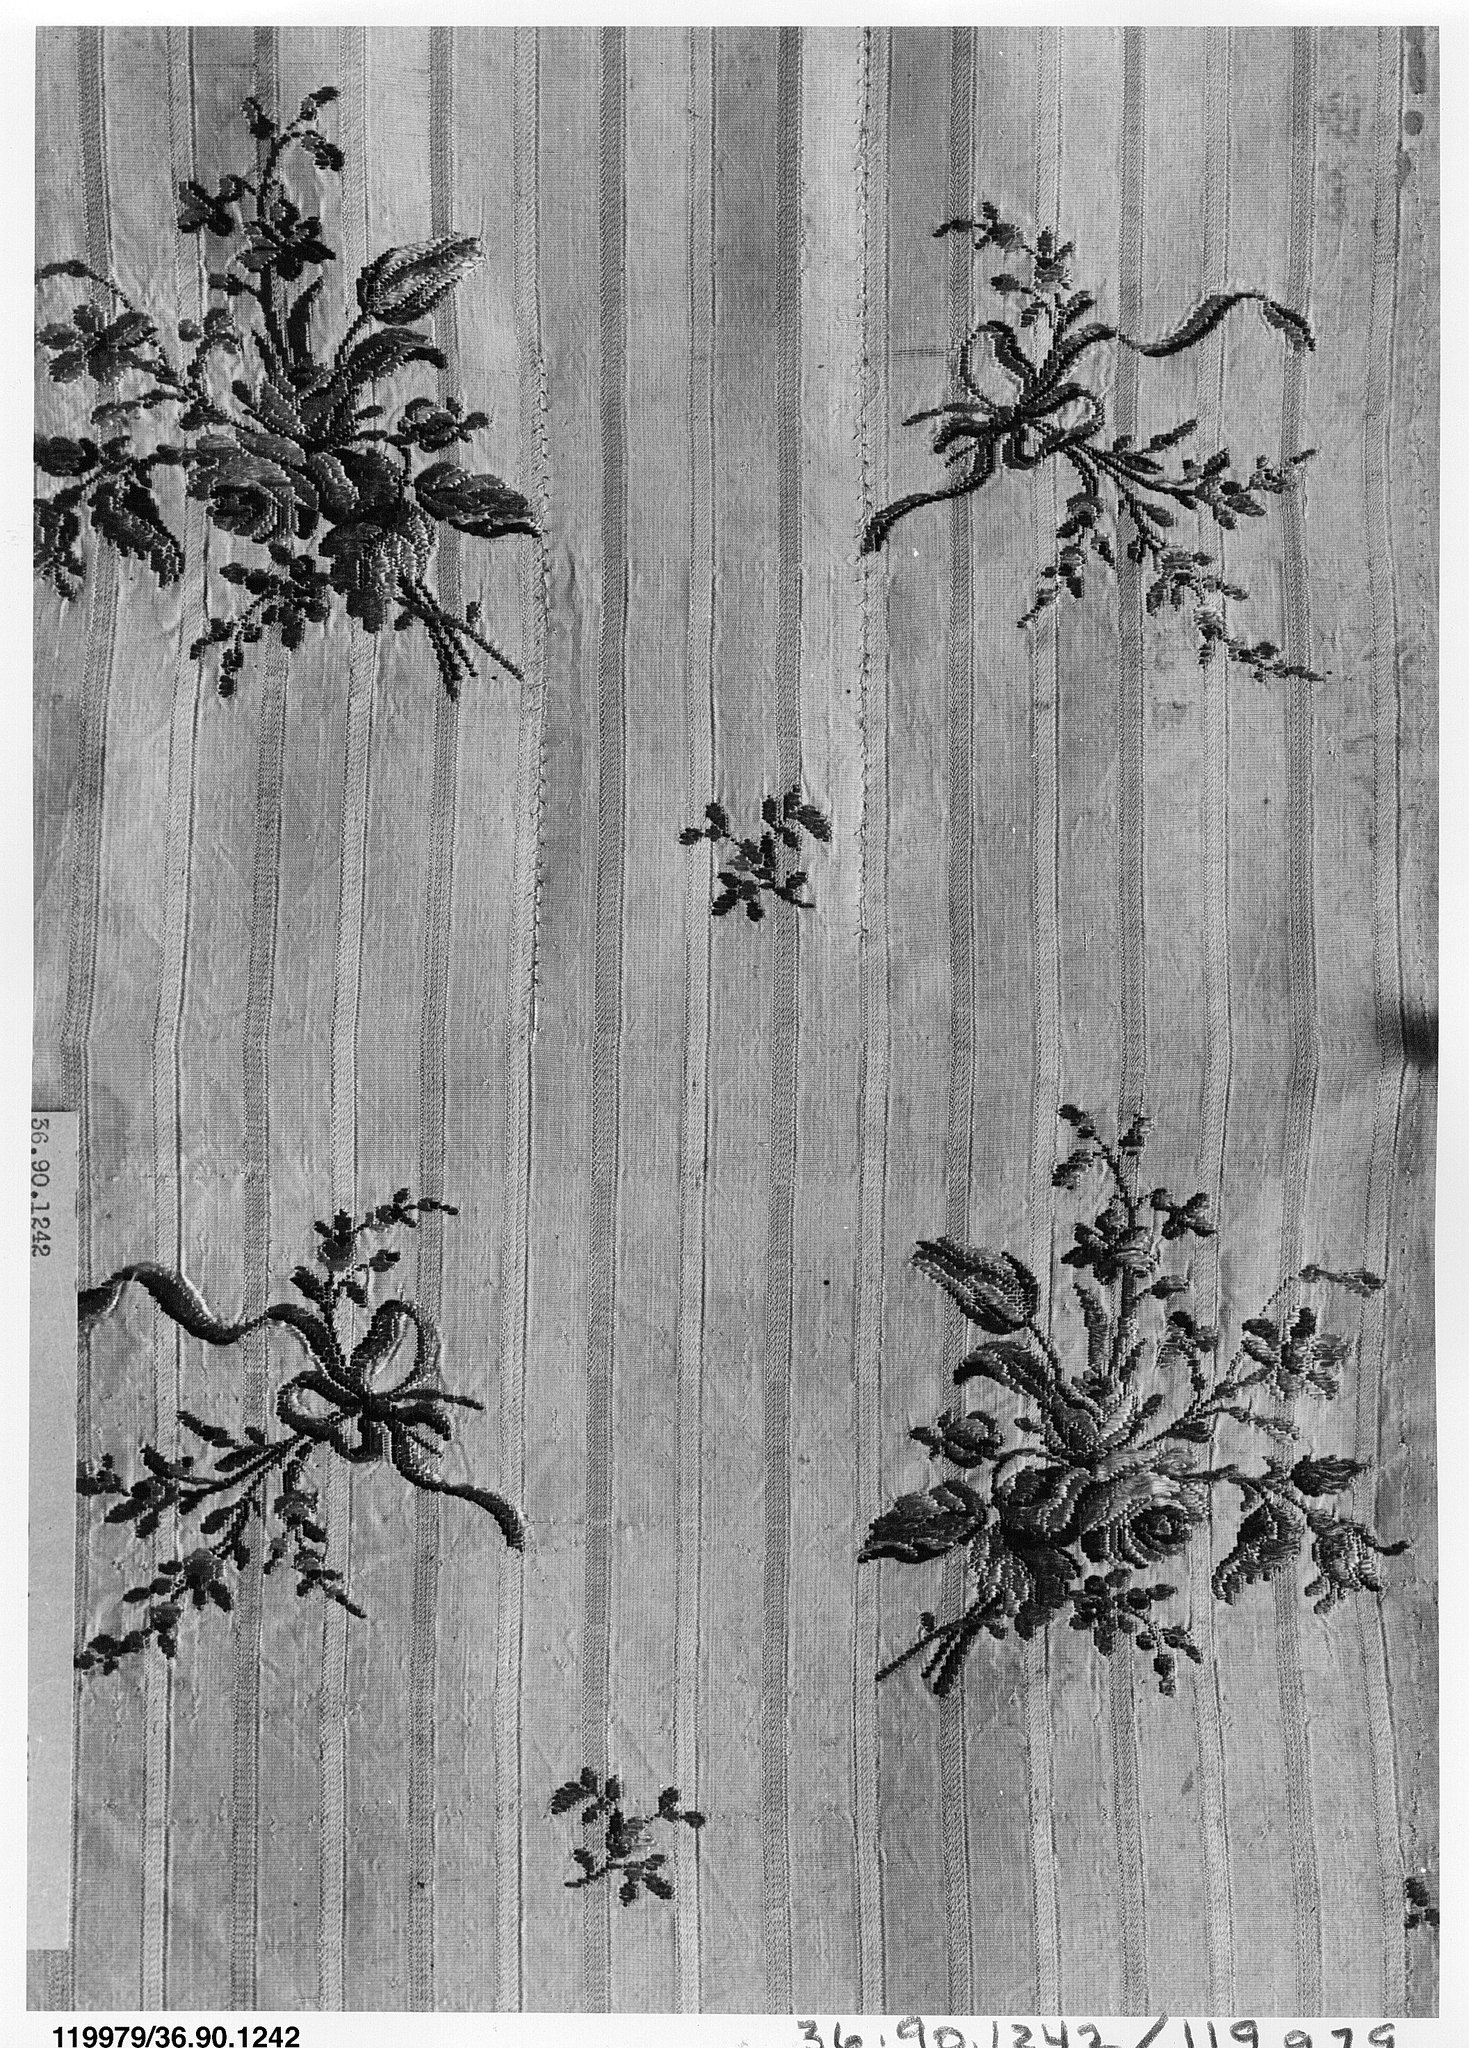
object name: piece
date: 1701-1800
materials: silk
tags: flowers,leaves